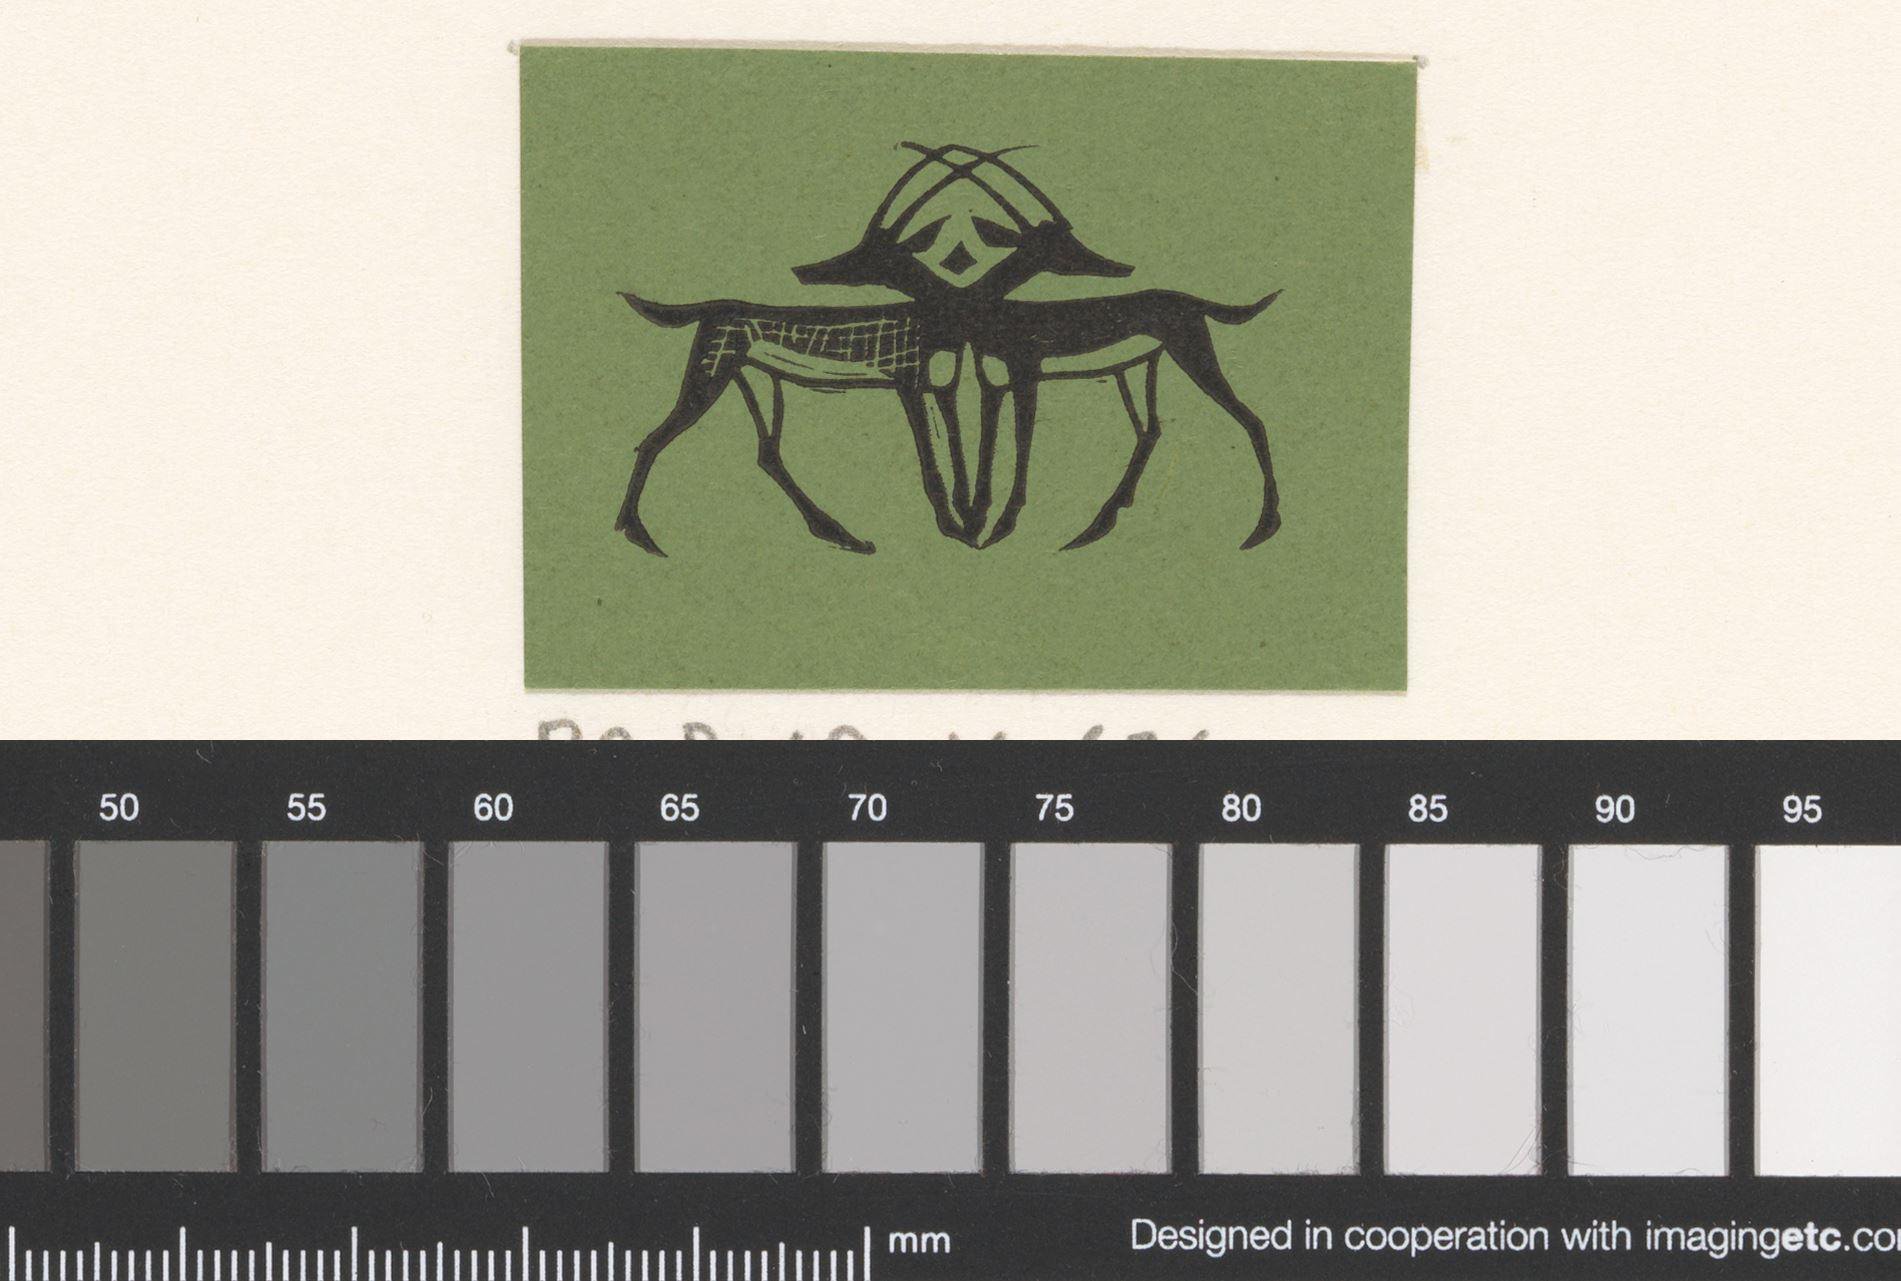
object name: print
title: Vignet met twee antilopen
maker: gerrit willem dijsselhof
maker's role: designer, draughtsman, print maker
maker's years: 1866-1924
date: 1892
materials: paper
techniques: woodcut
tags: hoofed animals: antelope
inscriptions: collector's mark: Lugt 2228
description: Gerrit Willem Dijsselhof vervaardigde zevenentwintig vignetten voor de gedichtenbundel 'Verzen' van Willem Kloos, die zou verschijnen bij de uitgeverij W. Versluys. Dit vignet is er daar één van. Hoewel de uitvoering van het boek in een ver stadium was, is het uiteindelijk nooit verschenen. De vignetten zijn later wel voor diverse andere doeleinden gebruikt.